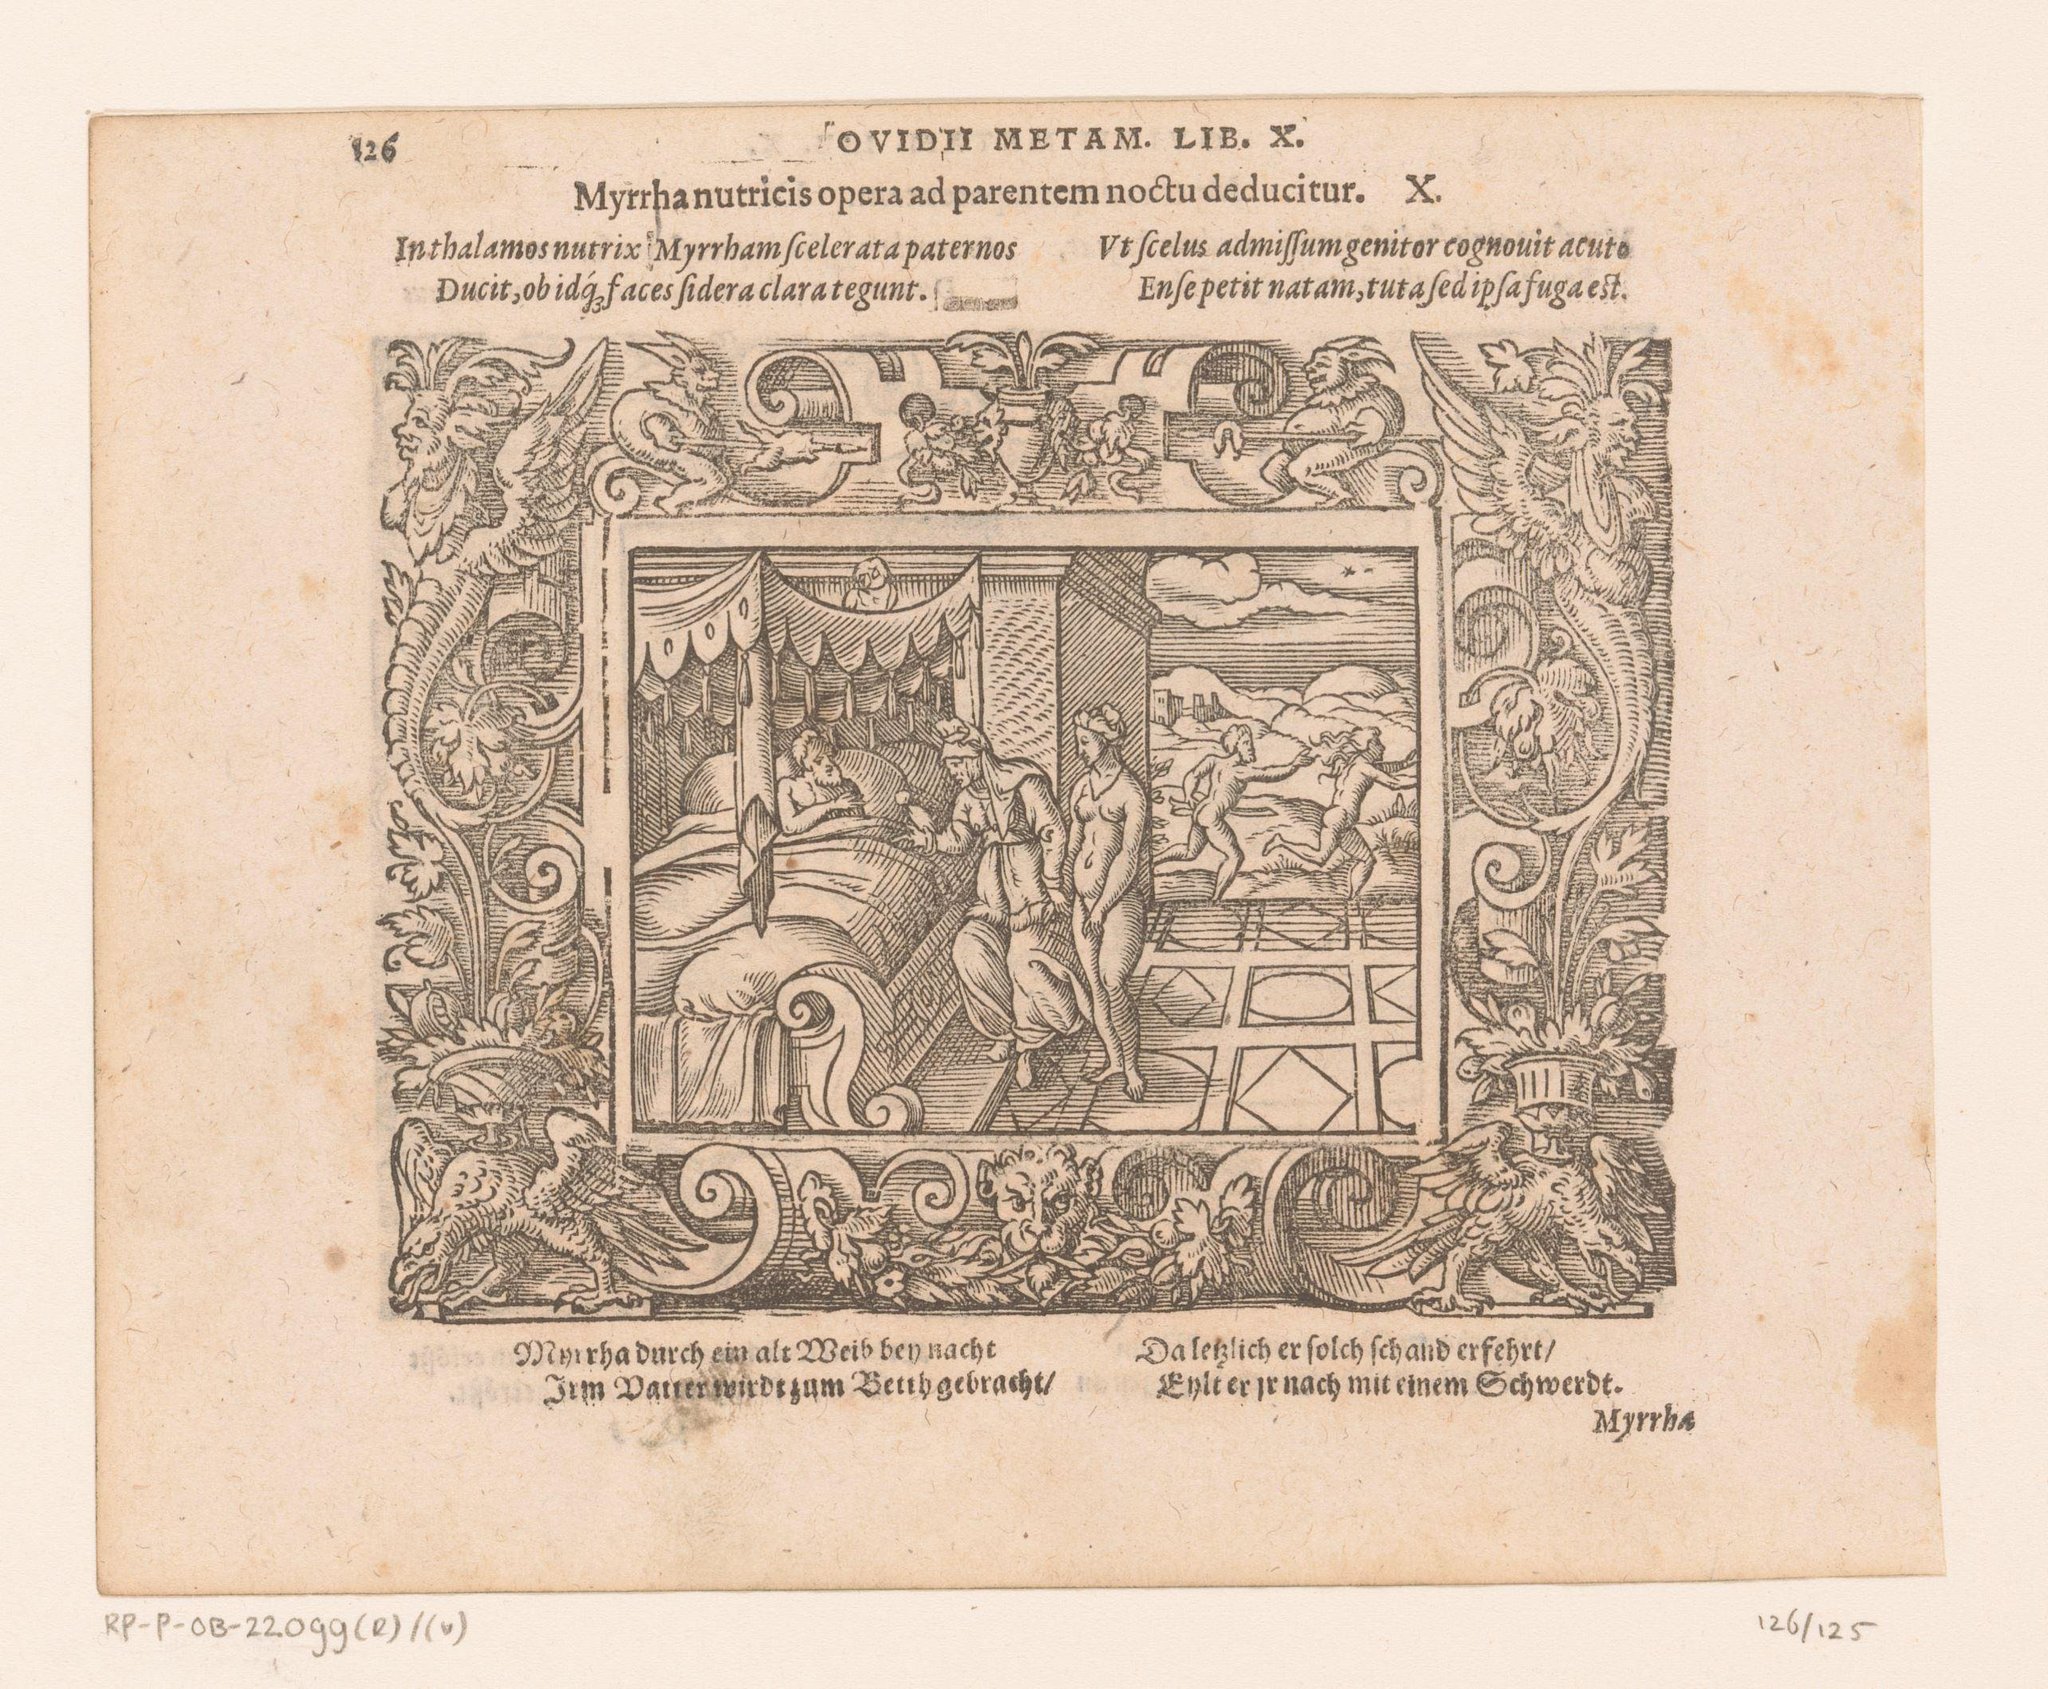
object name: print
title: Myrrha nutricis opera ad parentem noctu deducitur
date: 1569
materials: paper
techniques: letterpress printing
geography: frankfurt am main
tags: scrollwork, strapwork ~ ornament, when cinyras discovers the incest, he attempts to kill his daughter, after her father cinyras had been made drunk, myrrha is led by her nurse into his bed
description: Illustratie bij de Metamorfosen van Ovidius, afkomstig uit de publicatie: Posthius, Johannes. Tetrasticha in Ovidii metam. Frankfurt am Main: Georg Rab en Sigmund Feyerabend en erven Weigand Han, 1569. De voorstellingen en ornamentranden van deze boekillustraties zijn van twee aparte blokken gedrukt. Beide werden afzonderlijk van elkaar ook gebruikt voor andere publicaties, en de ornamentranden werden eveneens binnen deze publicatie meerdere keren gebruikt.